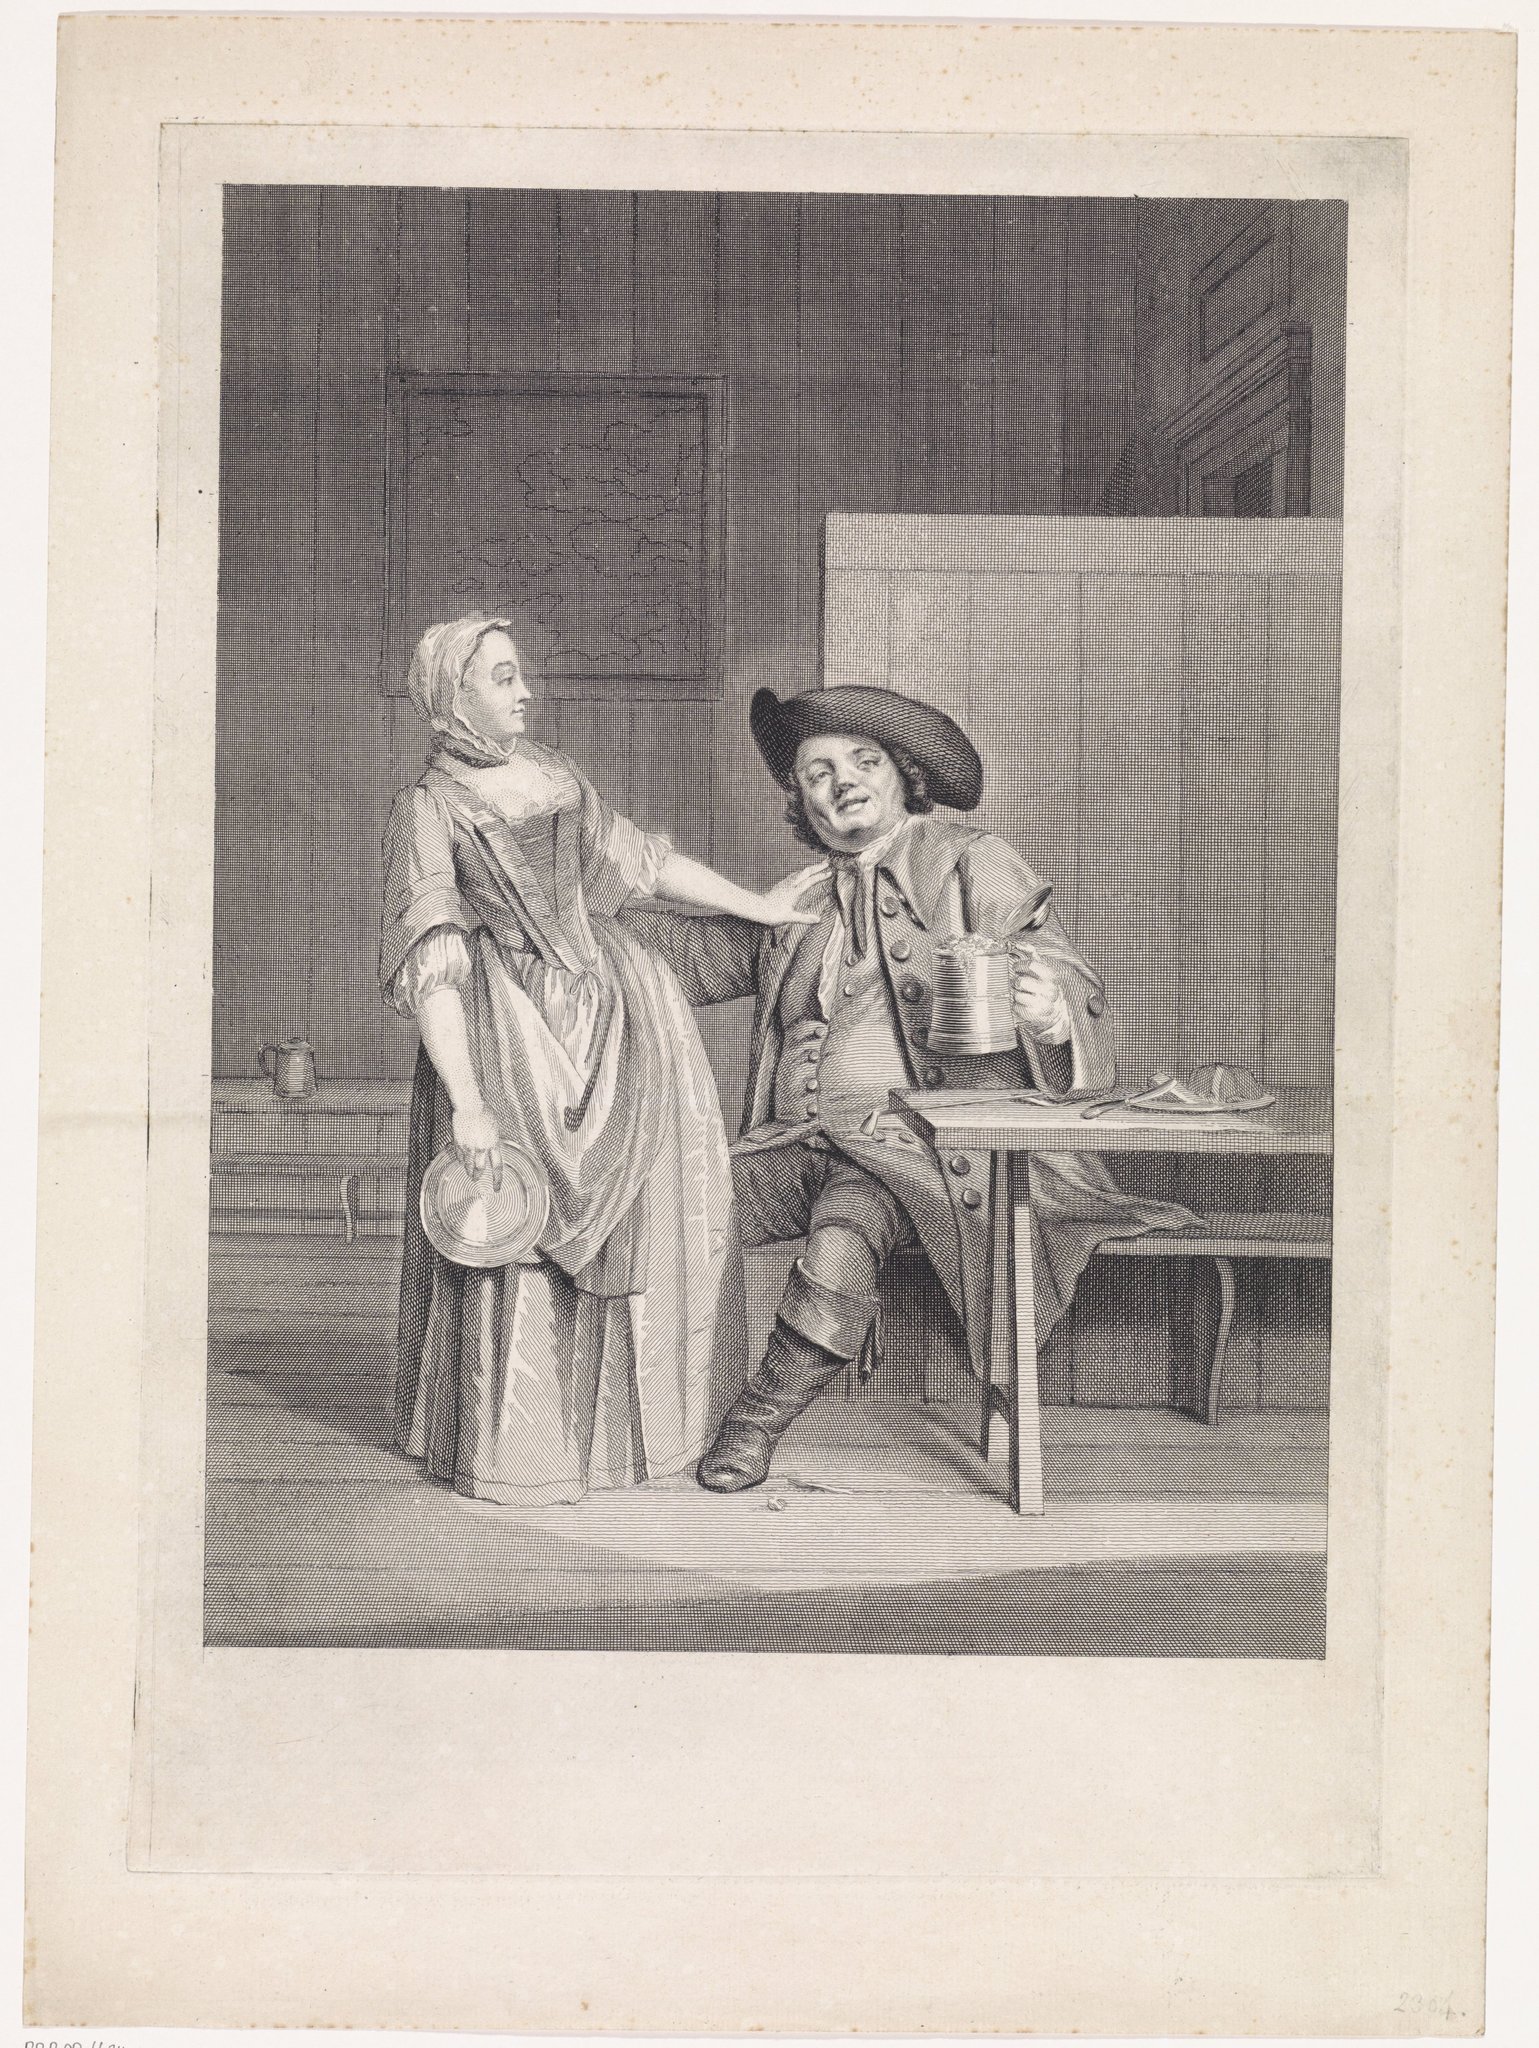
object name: print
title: Koetsier in een herberg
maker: jan punt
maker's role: draughtsman, print maker, publisher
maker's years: 1711-1779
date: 1756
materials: paper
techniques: engraving, etching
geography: amsterdam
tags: inn, coffee-house, public house, etc., unsuccessful love affair; seduction, beer, ale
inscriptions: collector's mark: Lugt 240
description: Een koetsier zit een een tafel in een herberg, met een grote kan bier in zijn hand. Hij probeert de waardin te verleiden, maar zij houdt hem af. Met een lege marge.